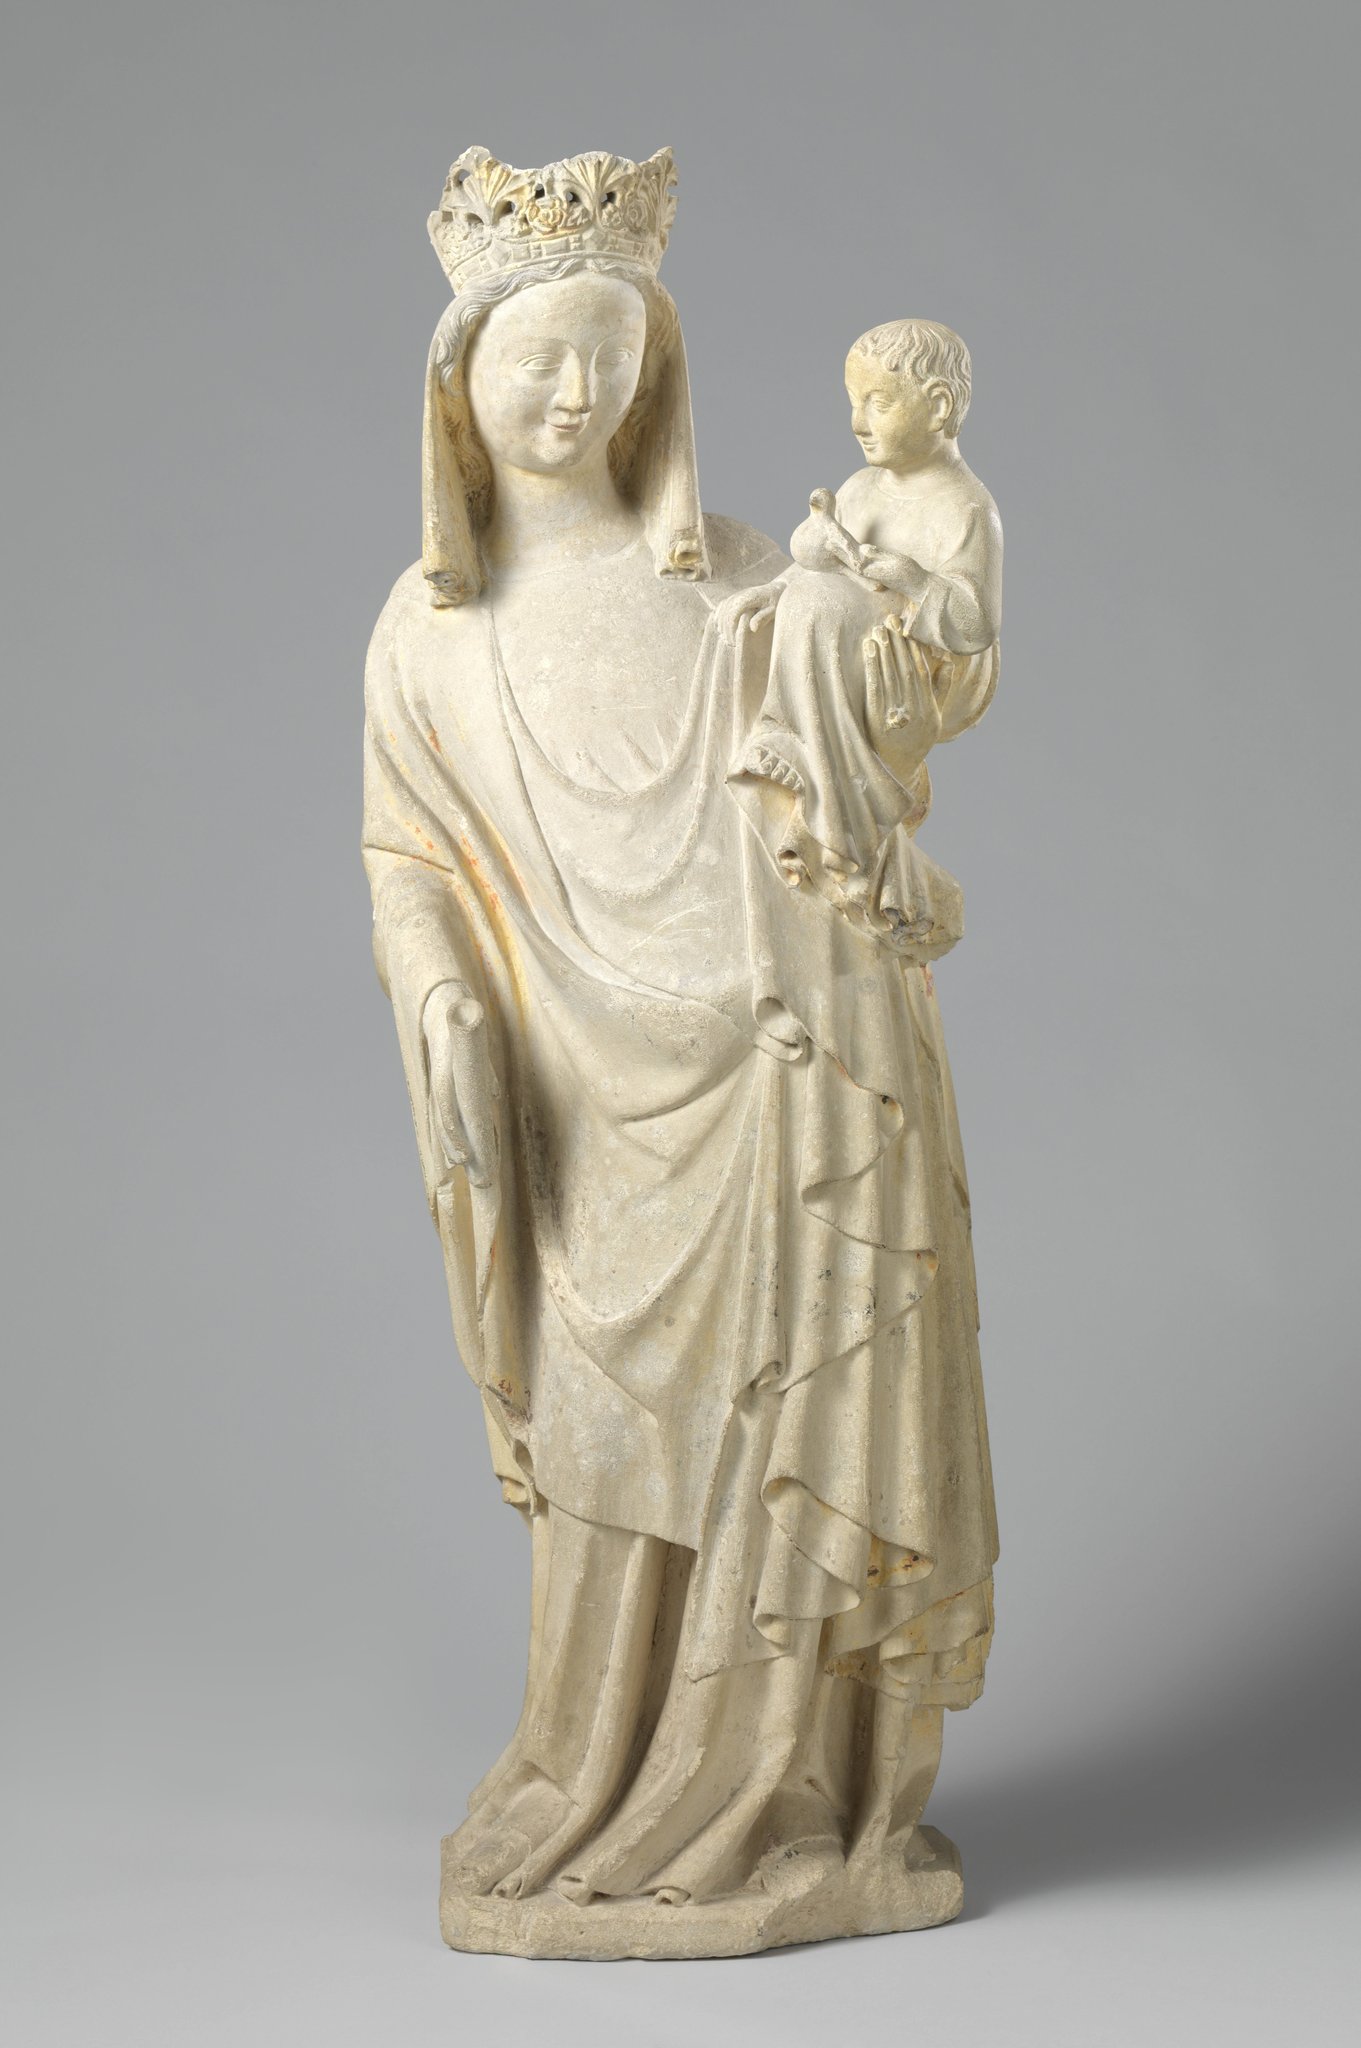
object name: sculpture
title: Virgin and Child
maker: Anonymous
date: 1350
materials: limestone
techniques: gilding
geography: normandy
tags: mary standing (or half-length), the christ-child sitting on her arm (christ-child to mary's left)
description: Statues of the Virgin with her son on her arm often depict him holding an attribute in his hand, such as an apple, a globe or, as here, a bird. This is a reference to his suffering on the cross. According to one legend, a bird tried to take a thorn from the crown of thorns on Christ’s head.